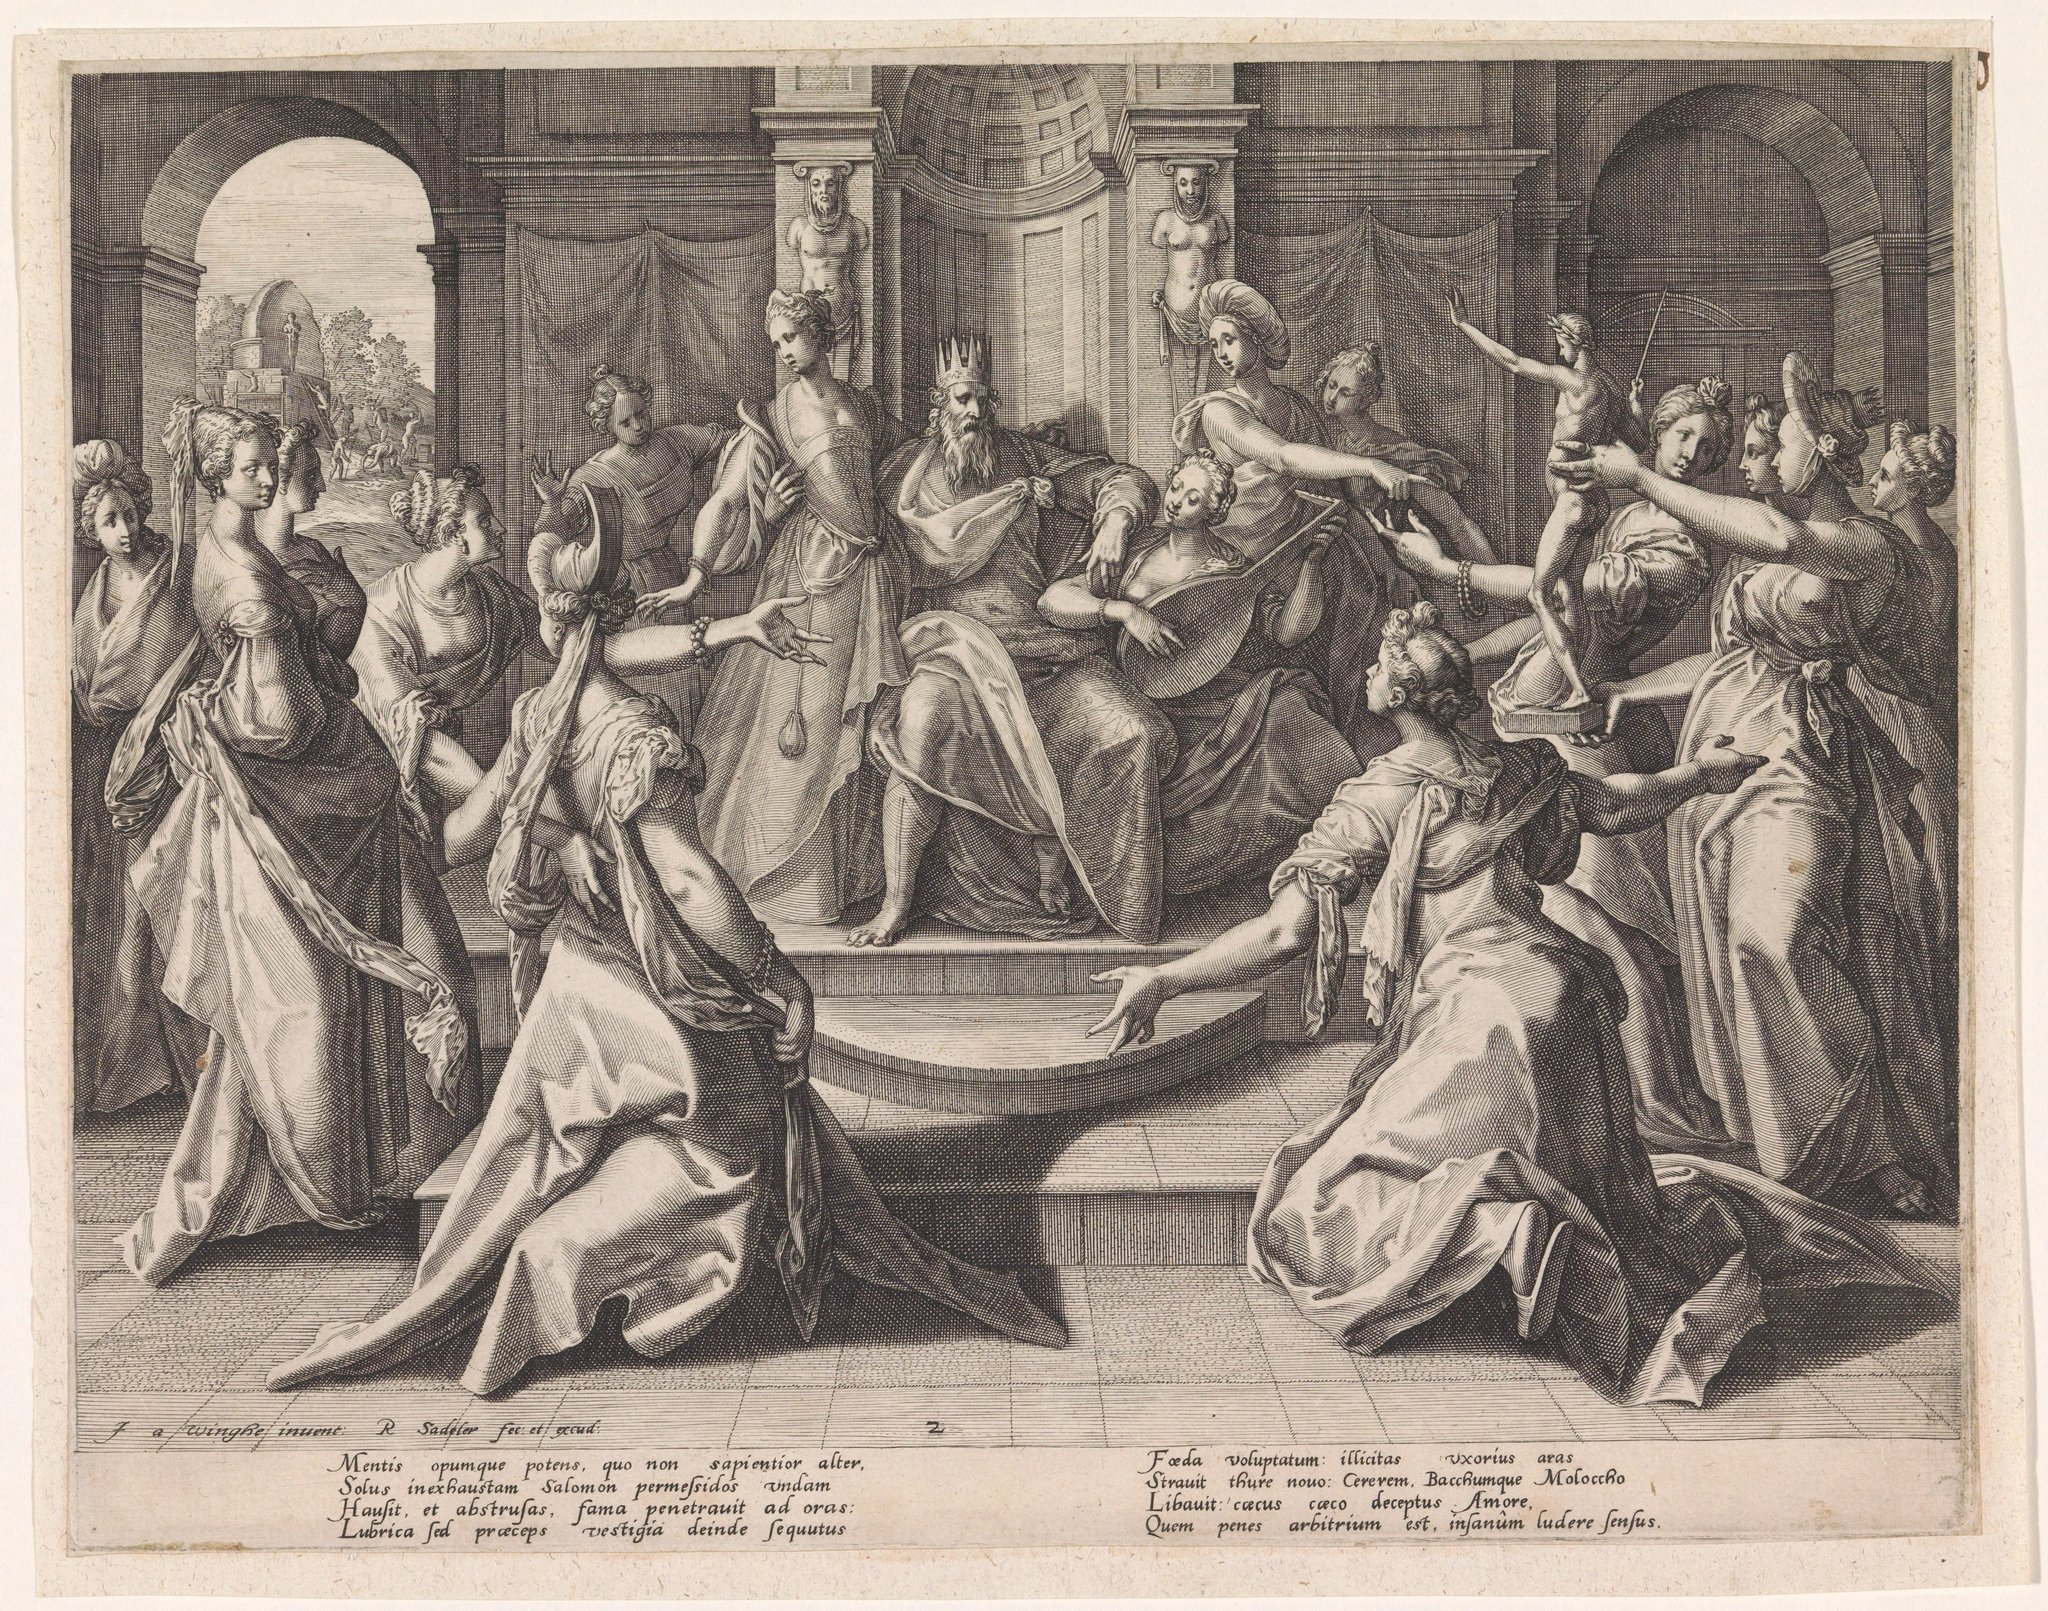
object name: print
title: Over de macht van vrouwen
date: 1589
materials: paper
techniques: engraving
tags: solomon's idolatry, pernicious influence of women, 'femmes fatales'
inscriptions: collector's mark: Lugt 2166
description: Koning Salomon zit op zijn troon, omringd door een gezelschap elegant geklede vrouwen. Een van hen bespeelt de luit. Een andere vrouw houdt hem een afgodsbeeld voor. Op de achtergrond links wordt een tempel voor een afgodsbeeld gebouwd